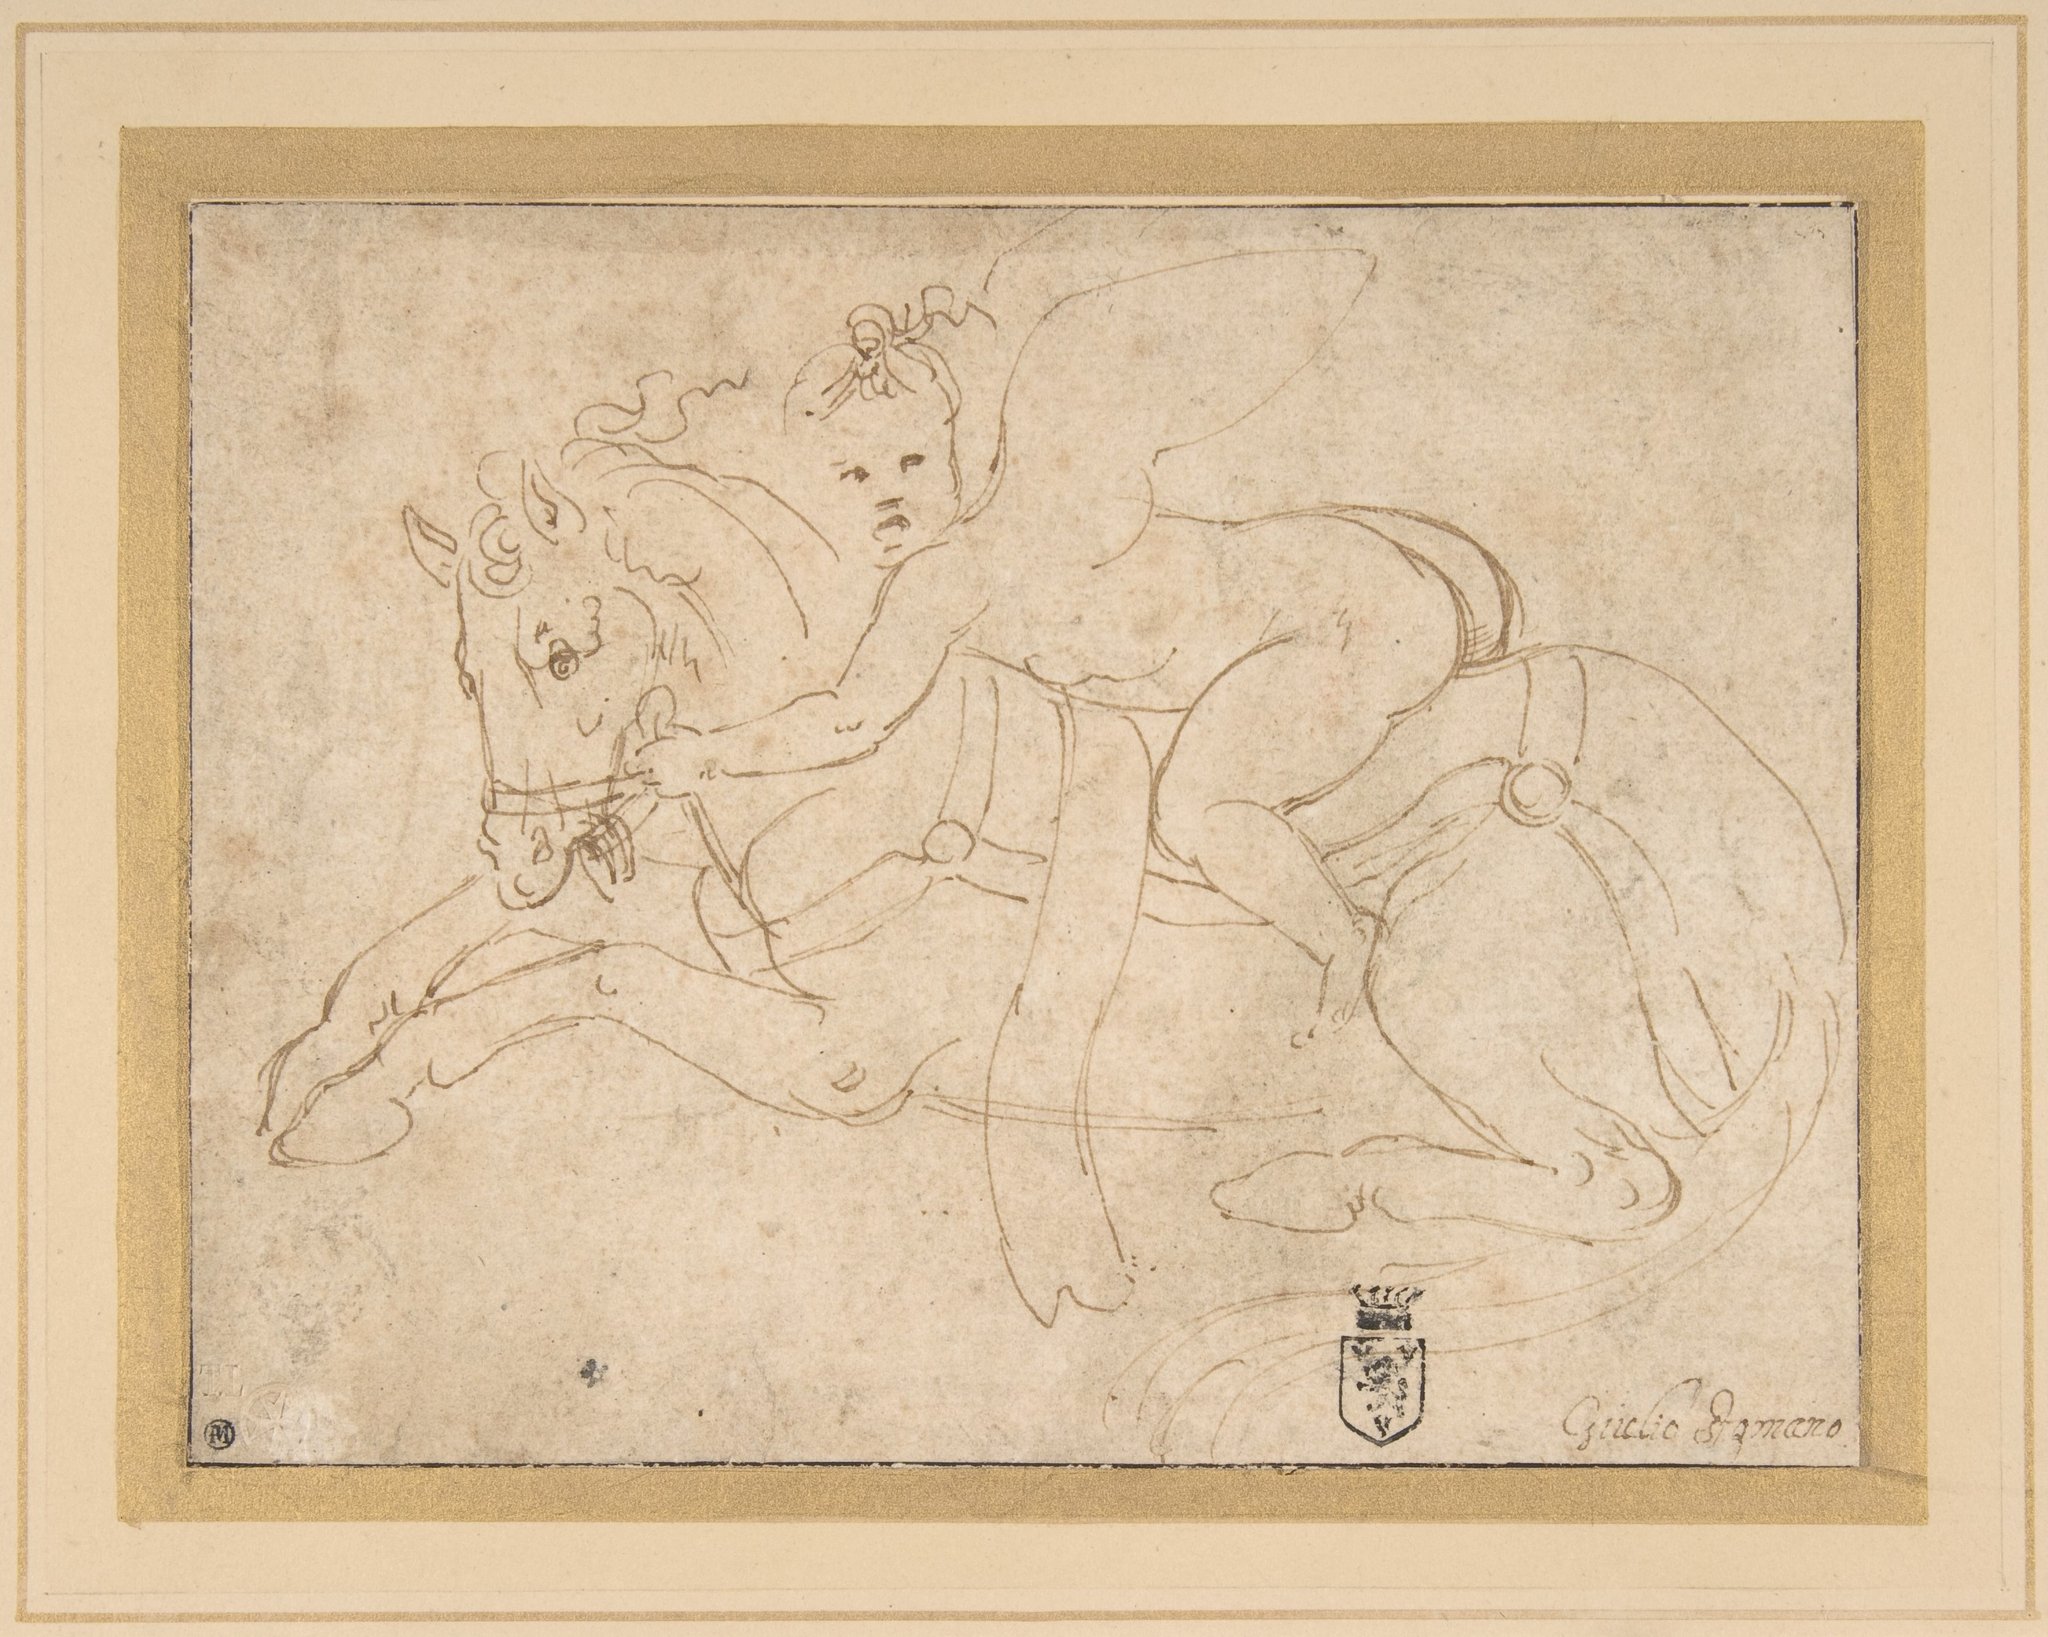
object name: drawing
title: Winged Infant Riding a Crouching Horse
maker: giulio romano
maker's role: artist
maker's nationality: italian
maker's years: 1499-1546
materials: ink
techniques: pen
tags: horses